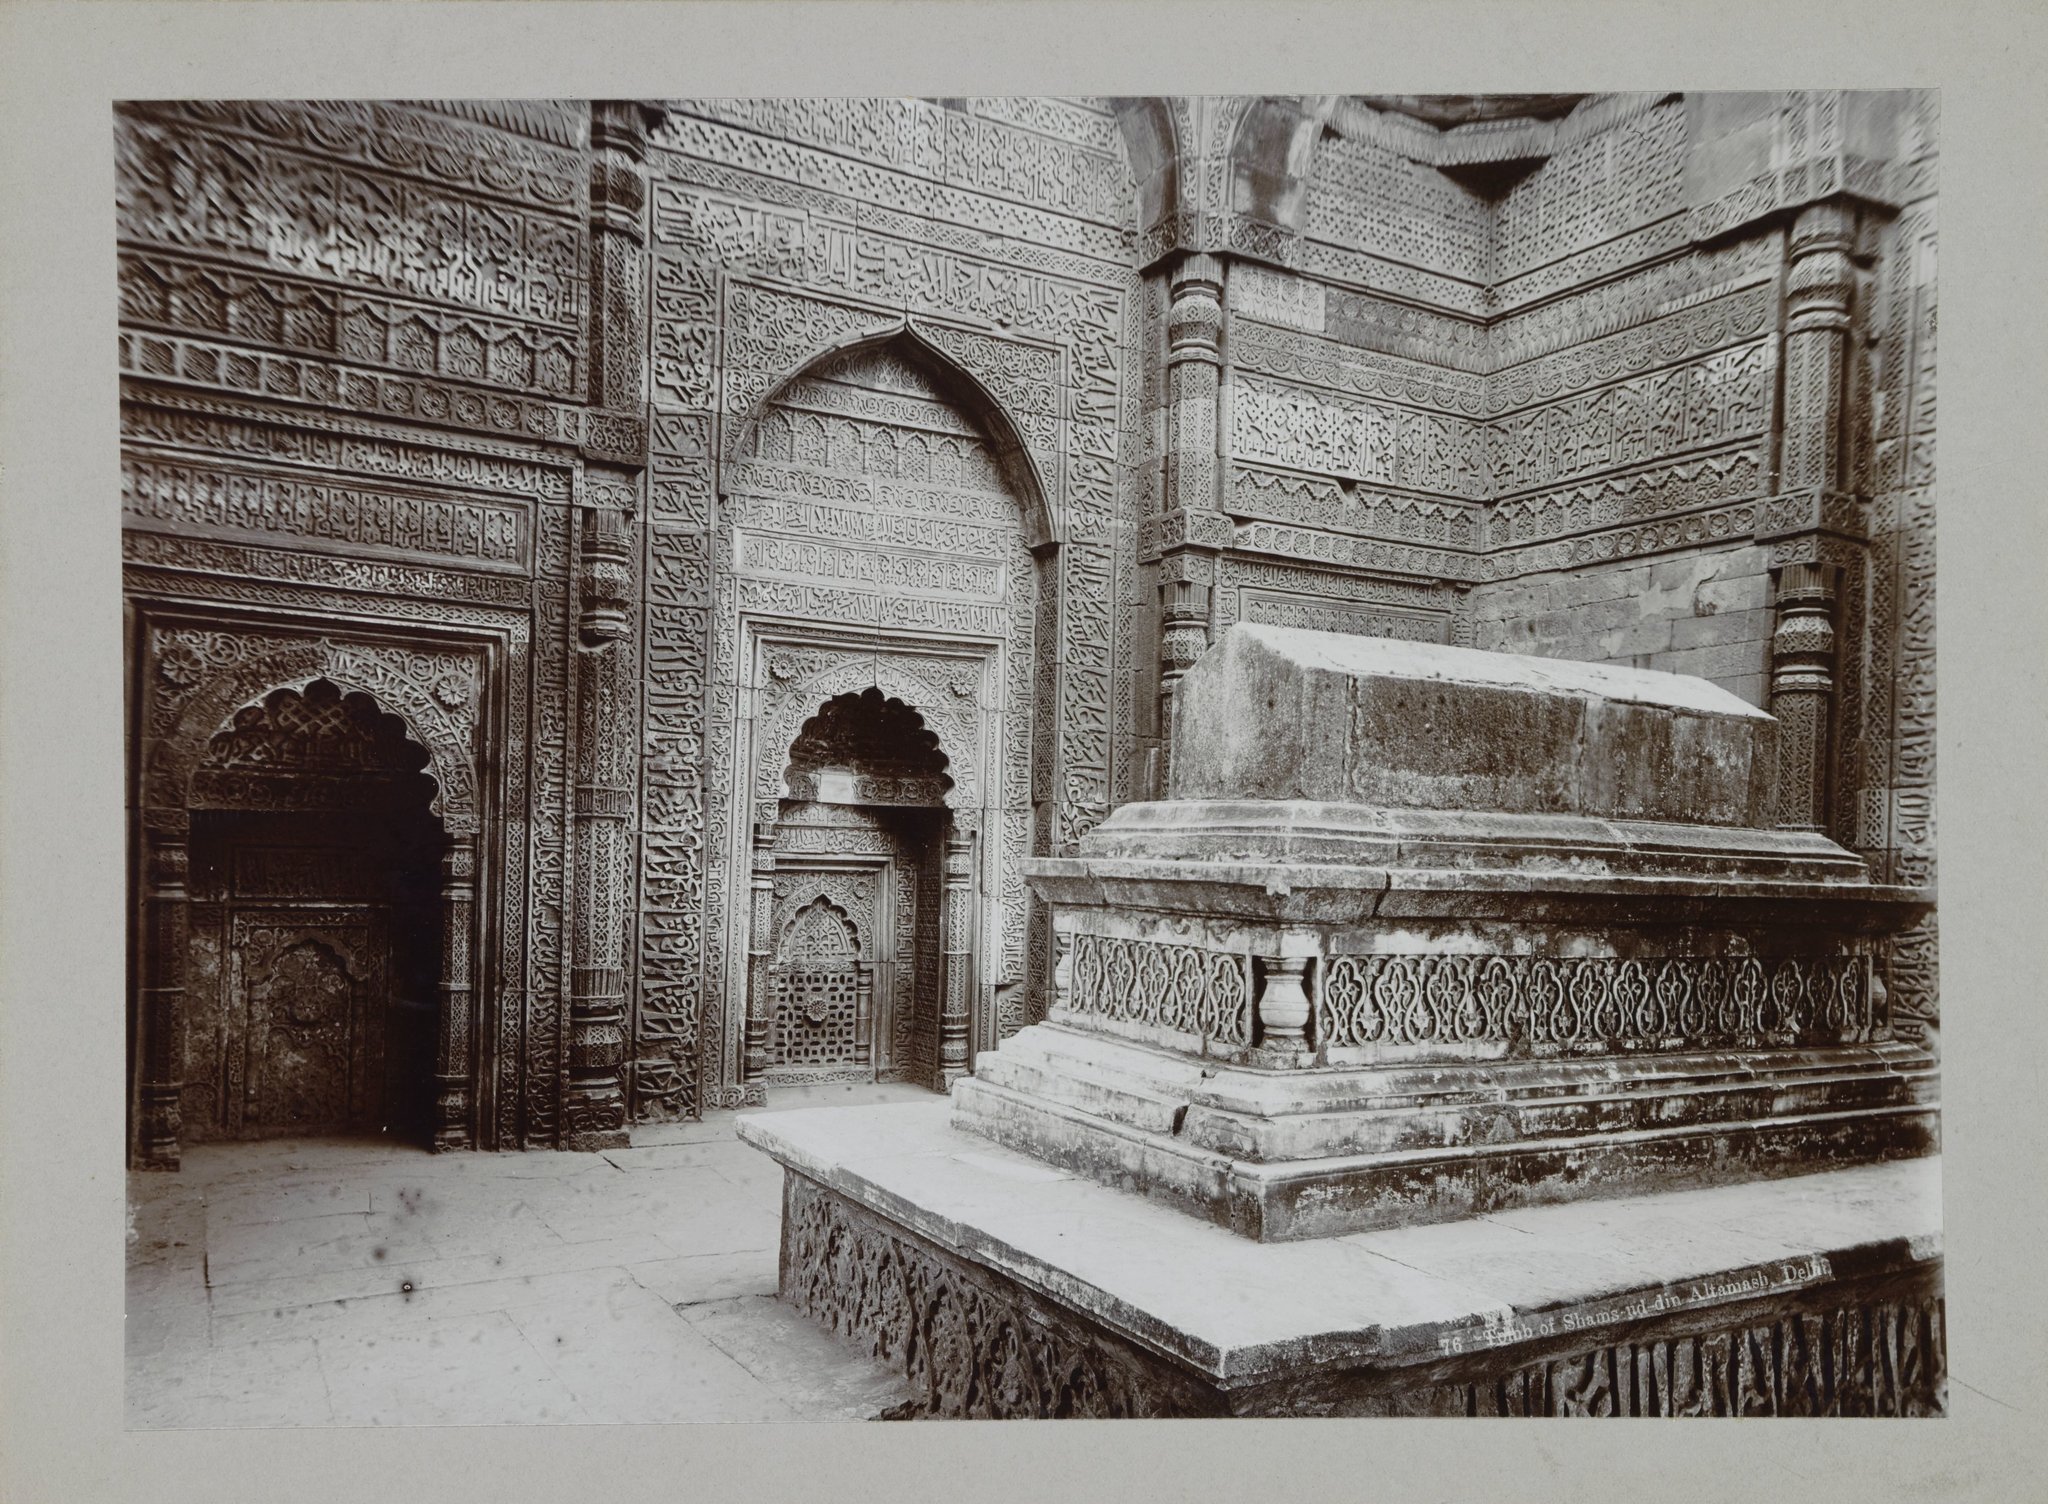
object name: photograph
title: Tomb of Iltutmish in the Qutb complex, Delhi, India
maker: Anonymous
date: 1895-1915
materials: cardboard, paper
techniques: gelatin silver print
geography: delhi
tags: delhi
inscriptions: annotation: ‘44. Graf i/d Rai Tithauca tempel.’, inscription: ‘76 Tomb of Shams-ud-din Altamash, Delhi’